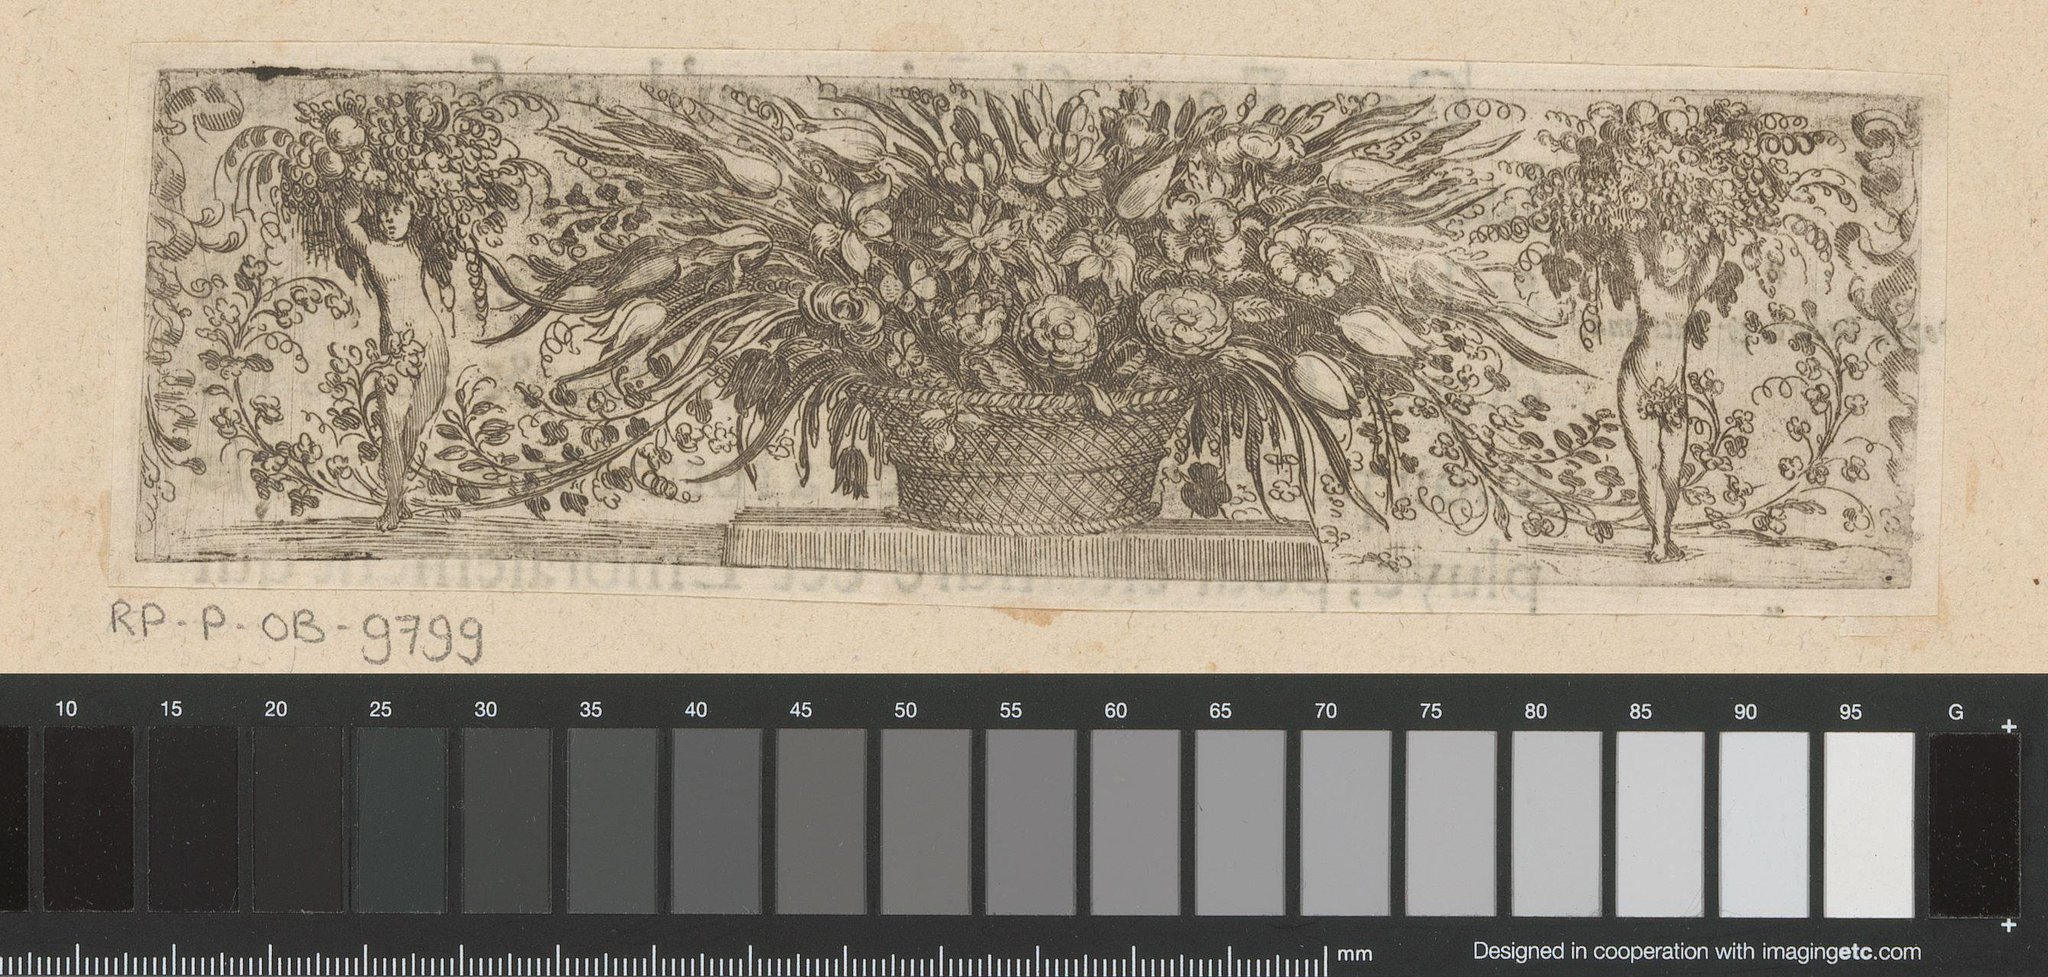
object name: book illustration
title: Monumenten en feestelijkheden tijdens intocht van Karel IV in Nancy, 1641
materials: paper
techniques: etching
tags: cut flowers; nosegay, bunch of flowers, ornaments ~ art, container made of plant material other than wood: basket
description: Prent uit: Bardin, Philippe. Le Triomphe De Son Altesse Charles IIII (...). Nancy: Poirel, Dominique, Charlot Anthoine en Charlot Claude, 1664.